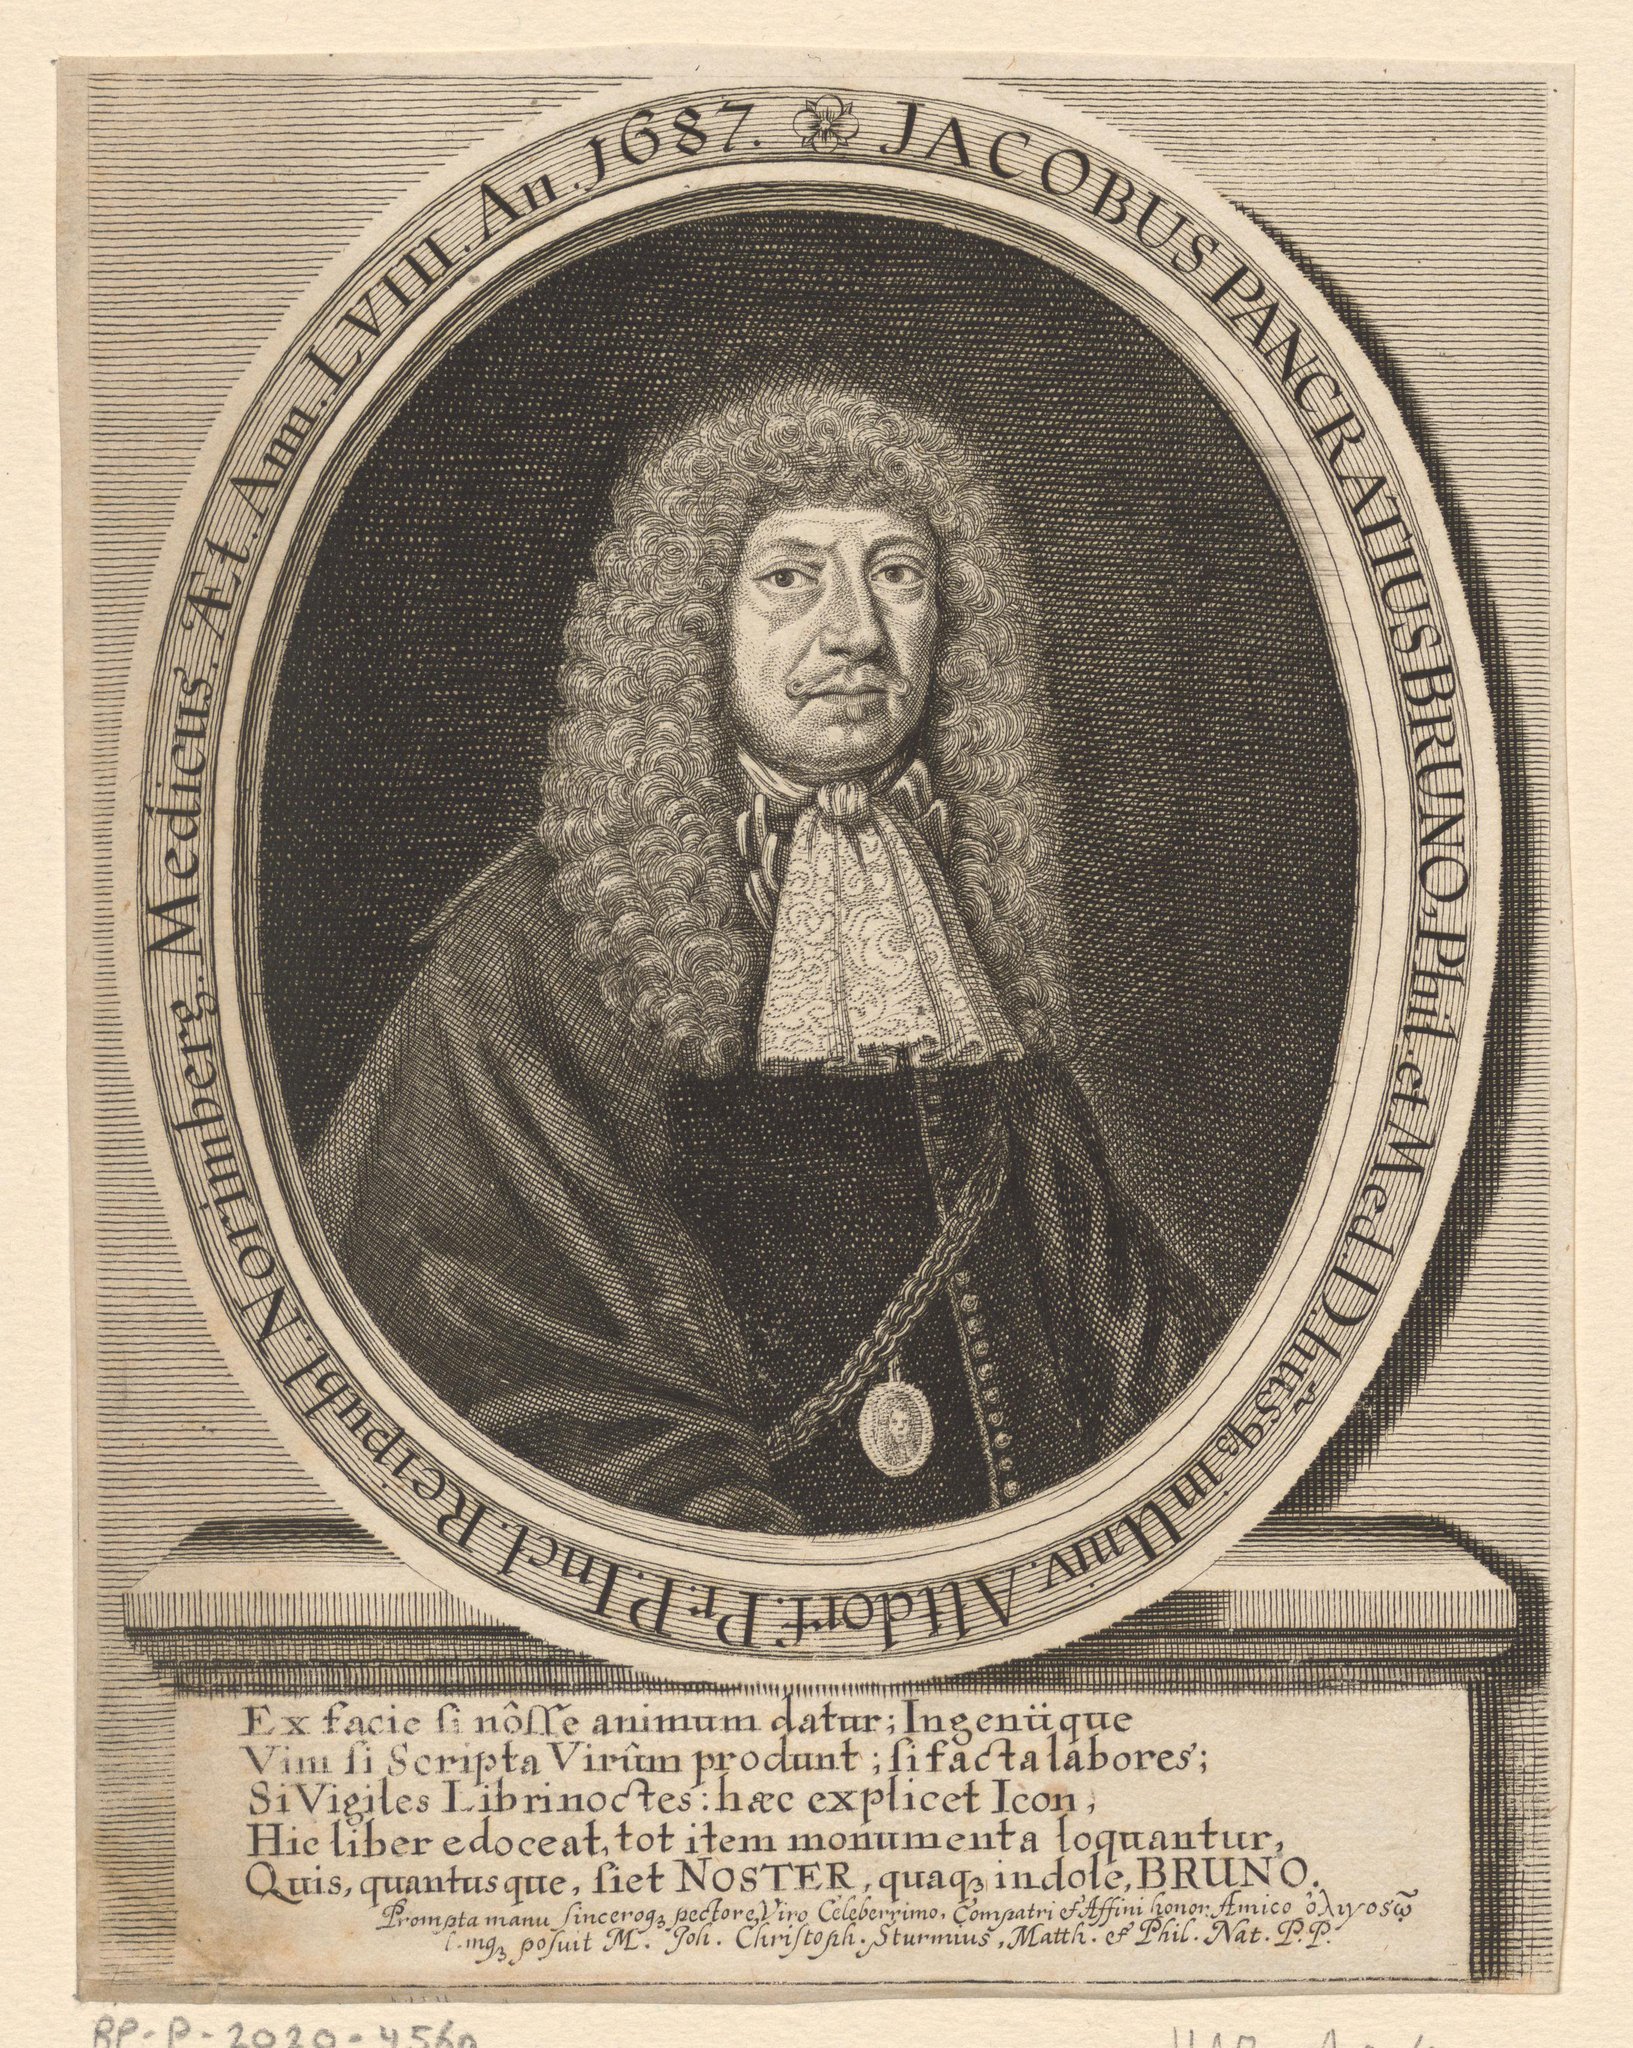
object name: print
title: Portret van Jacob Pancratius Bruno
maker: Anonymous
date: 1687-1724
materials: paper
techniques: engraving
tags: scholar, philosopher, historical persons